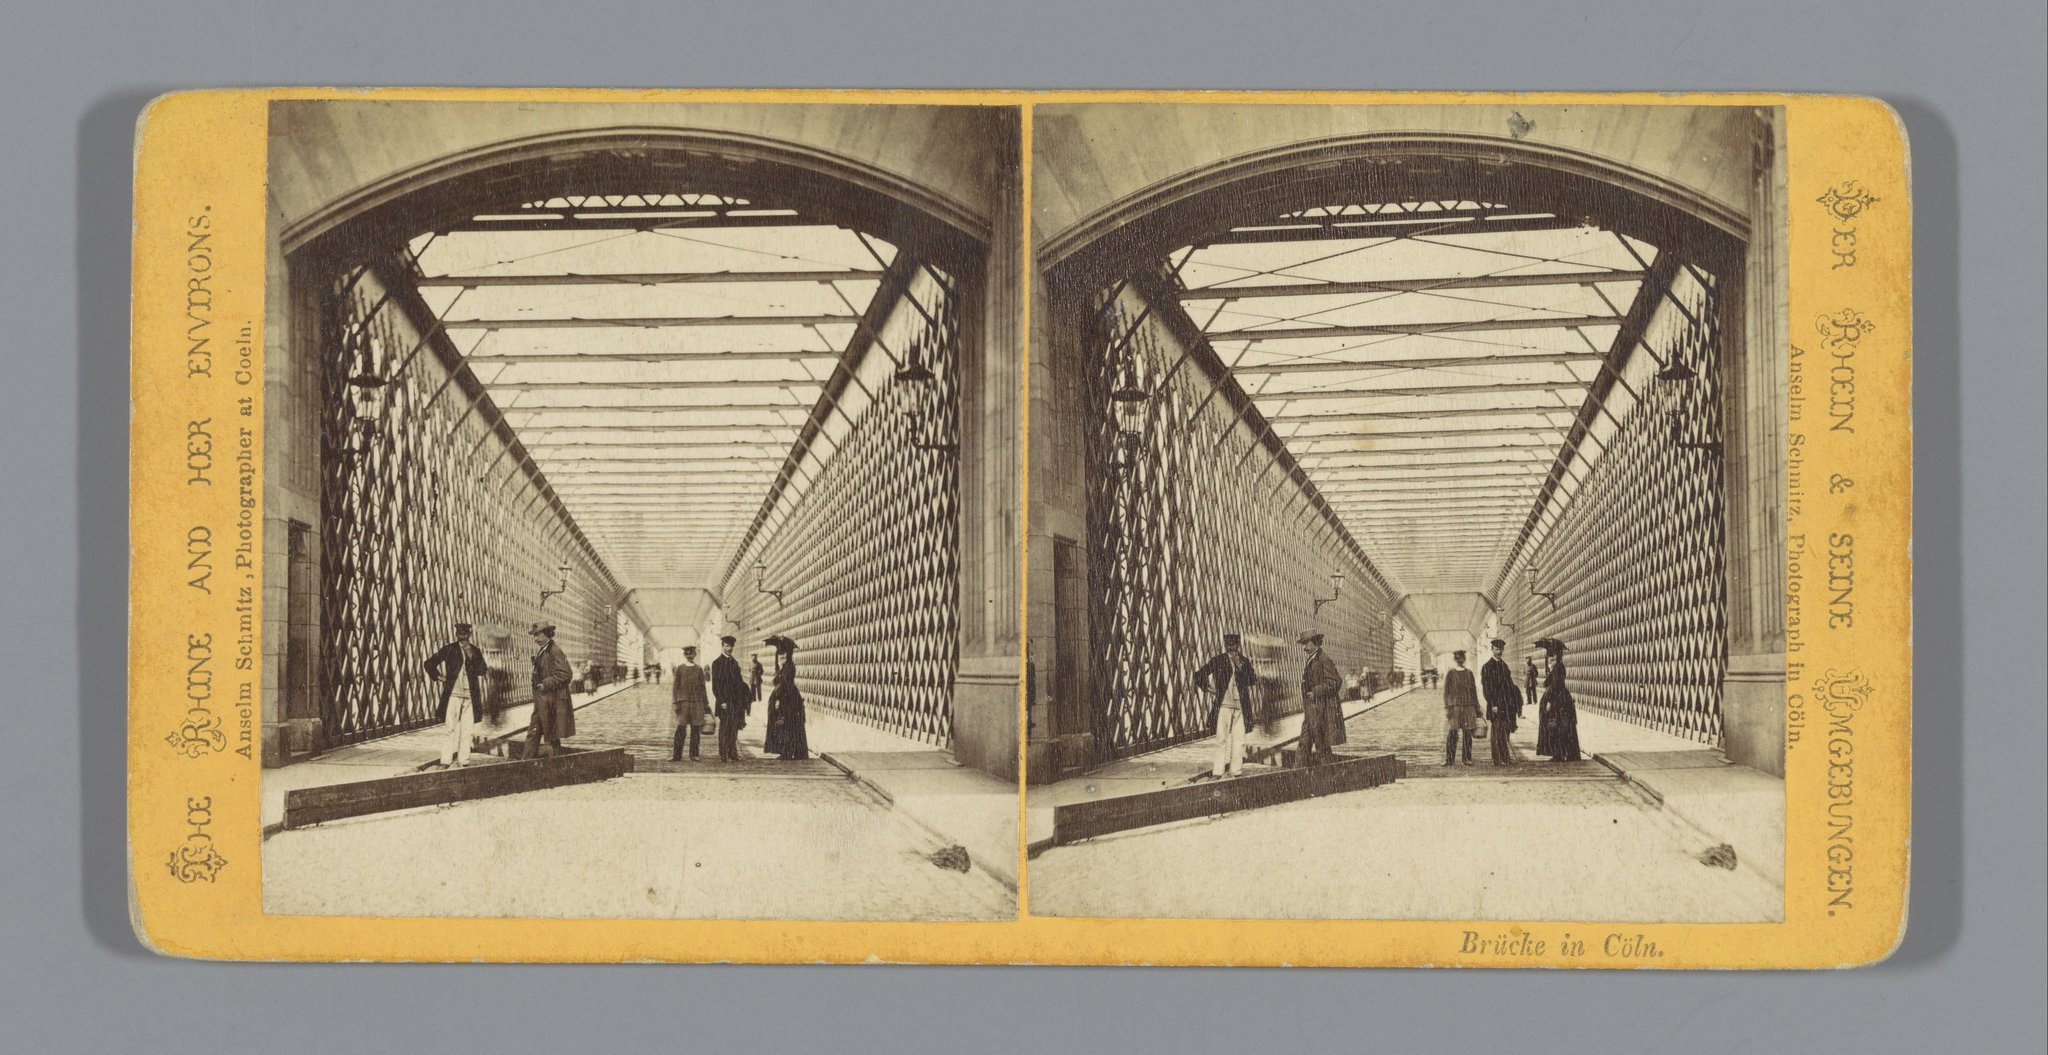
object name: stereograph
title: Brücke in Cöln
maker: anselm schmitz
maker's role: publisher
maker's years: 1831-1903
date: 1860-1870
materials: cardboard, photographic support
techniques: albumen print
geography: dombrücke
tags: bridge